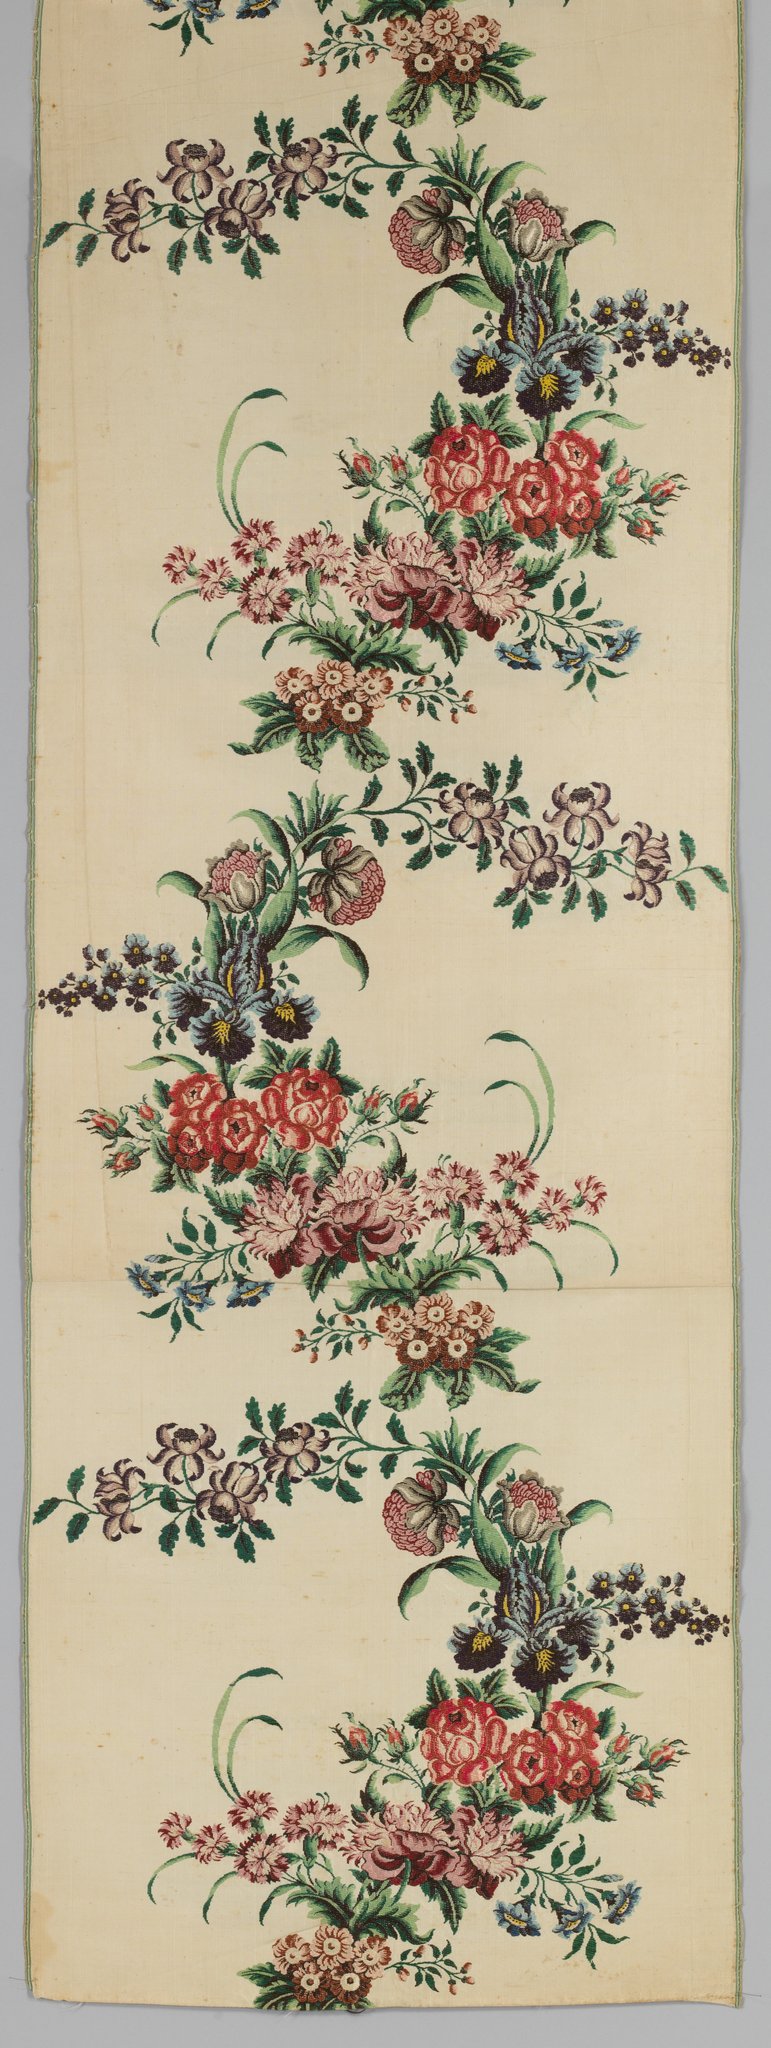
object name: panel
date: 1750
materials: silk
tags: flowers,leaves